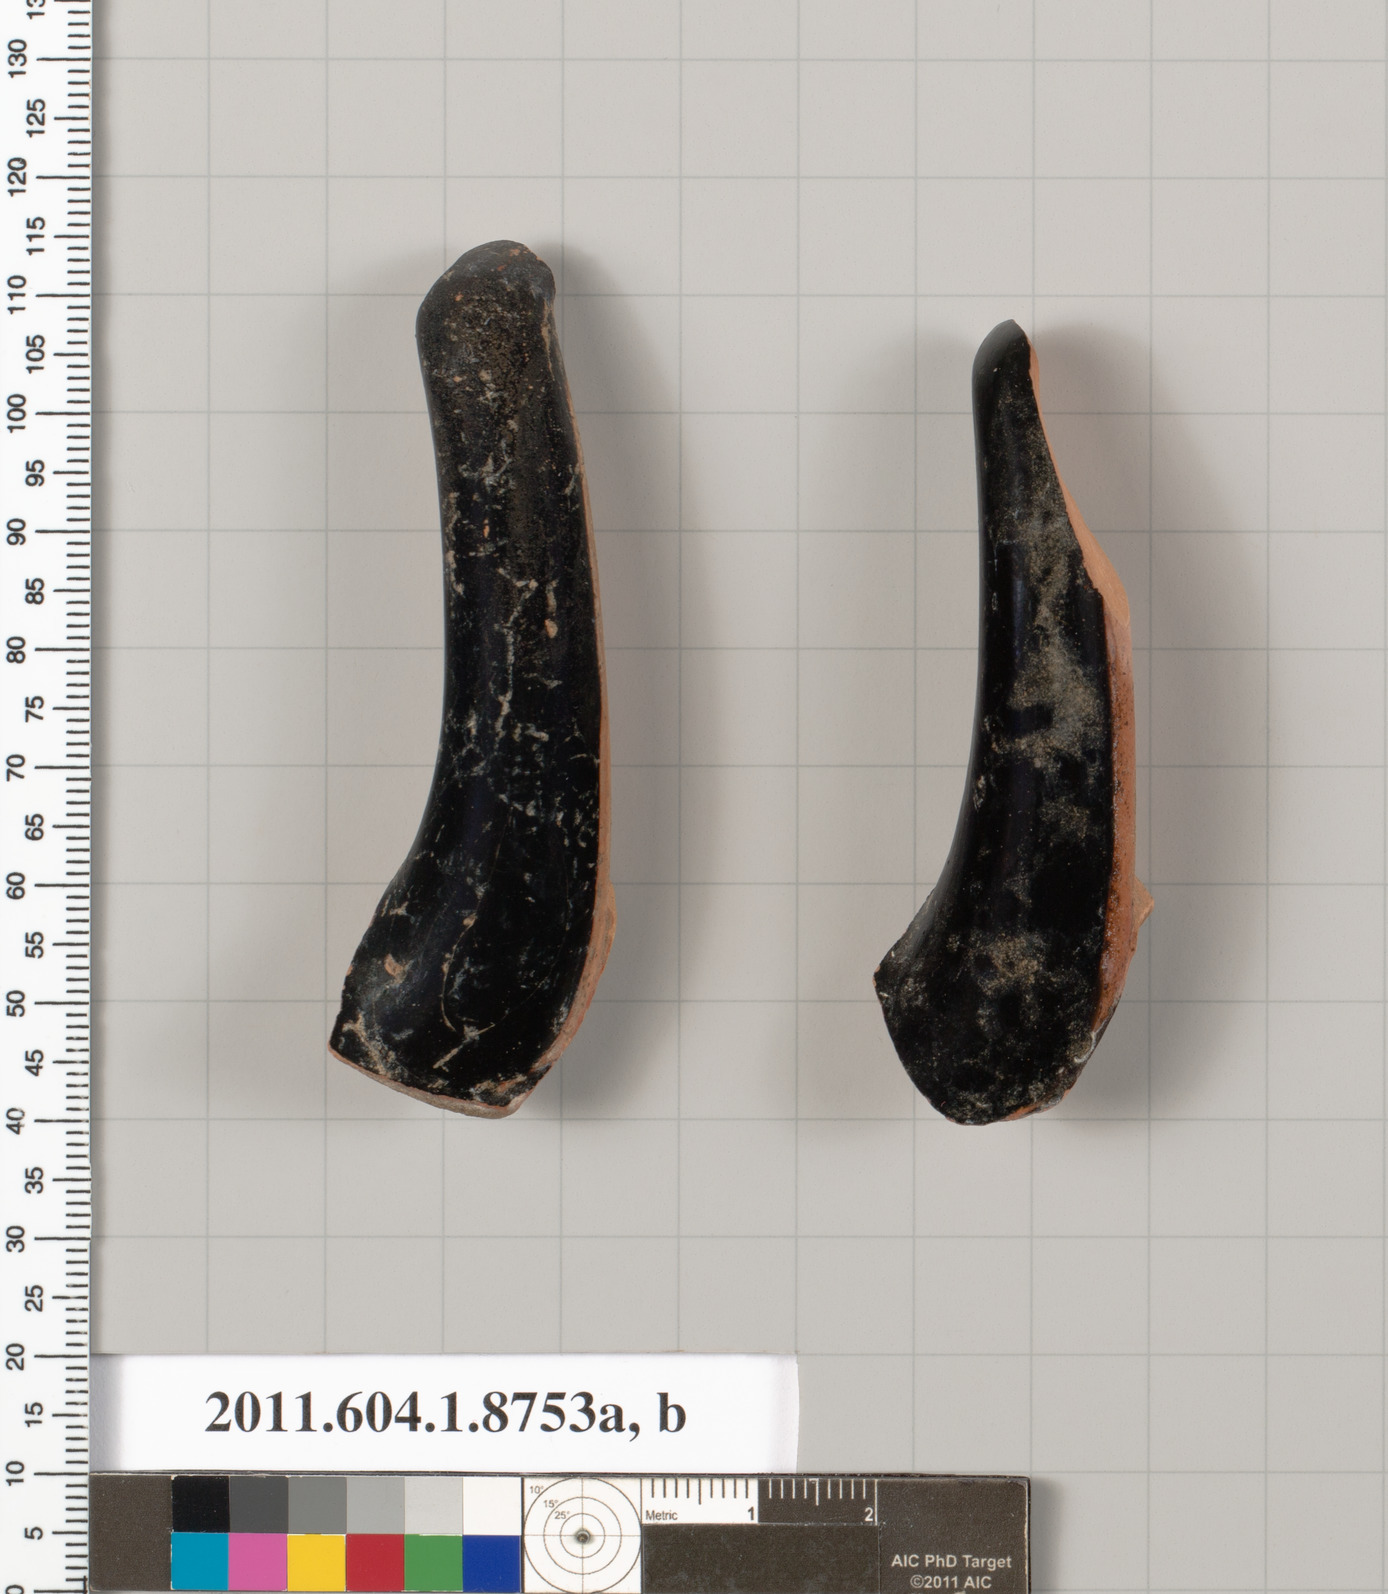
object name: kylix fragment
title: Terracotta fragments of kylikes (drinking cups)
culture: greek, attic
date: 475-451 BCE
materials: terracotta